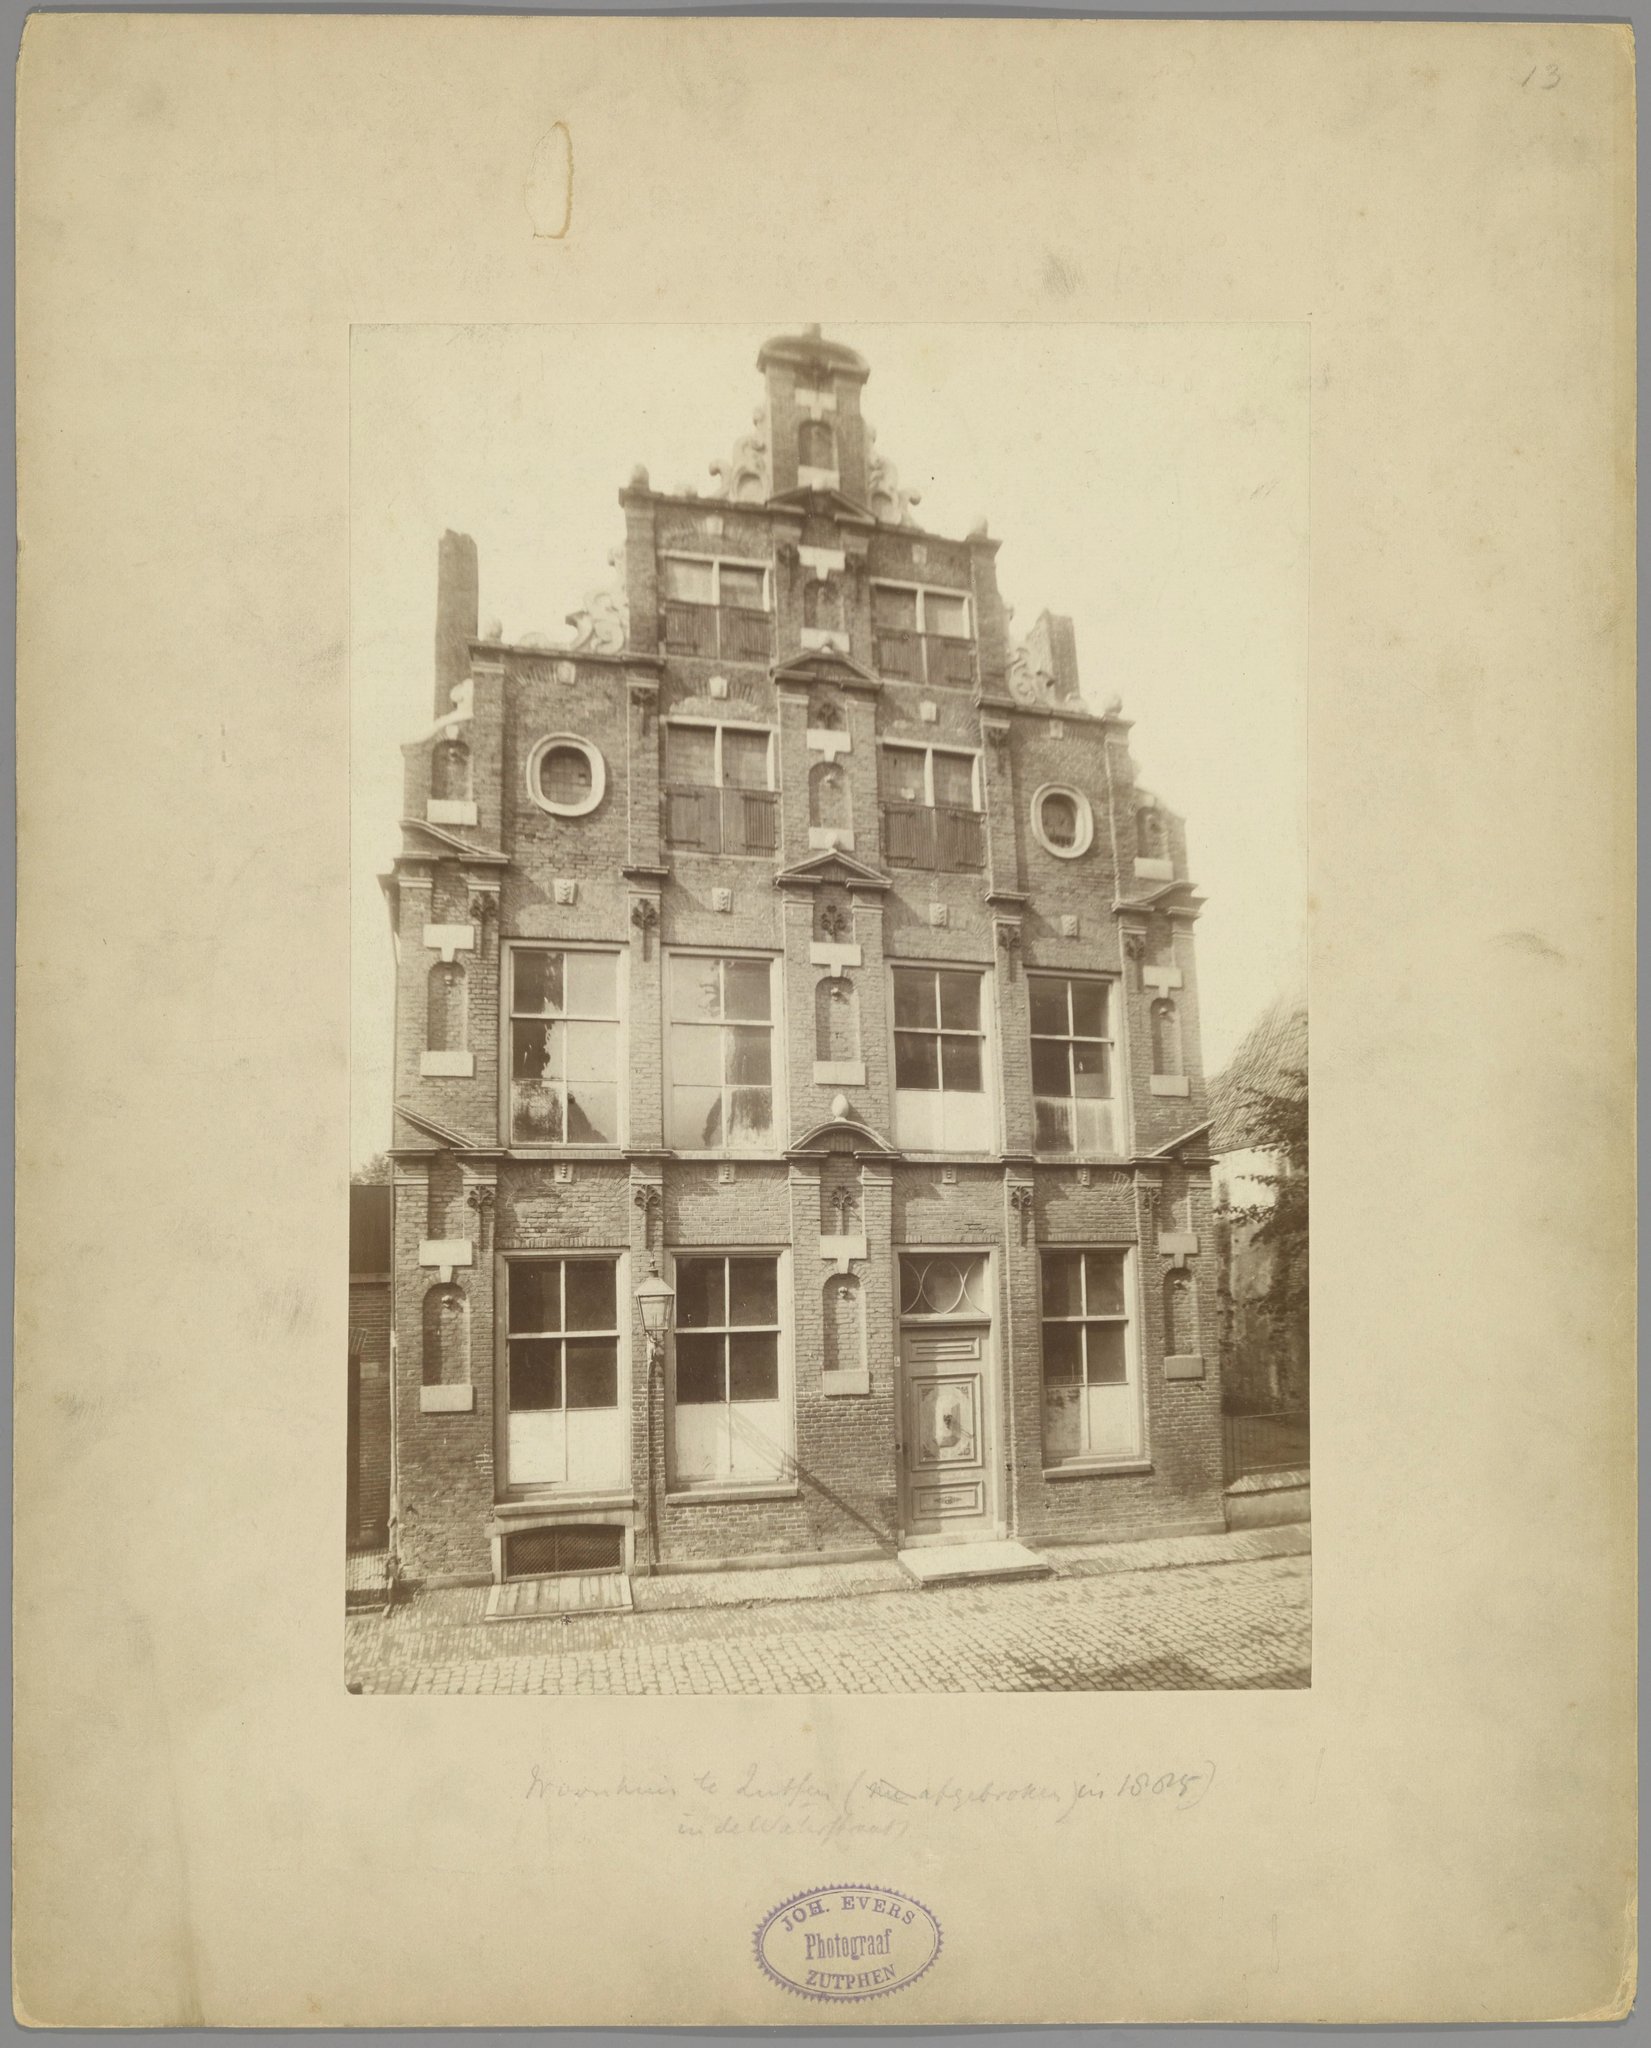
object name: photograph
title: Woonhuis te Zutphen ( afgebroken in 1885) in de Waterstraat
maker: joh. evers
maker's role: fotograaf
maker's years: 1858-1906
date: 1875-1900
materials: cardboard, photographic support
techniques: albumen print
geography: zutphen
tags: façade (of house or building)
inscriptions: collector's mark: Lugt 3937, name: ‘JOH. EVERS Photograaf Zutphen’